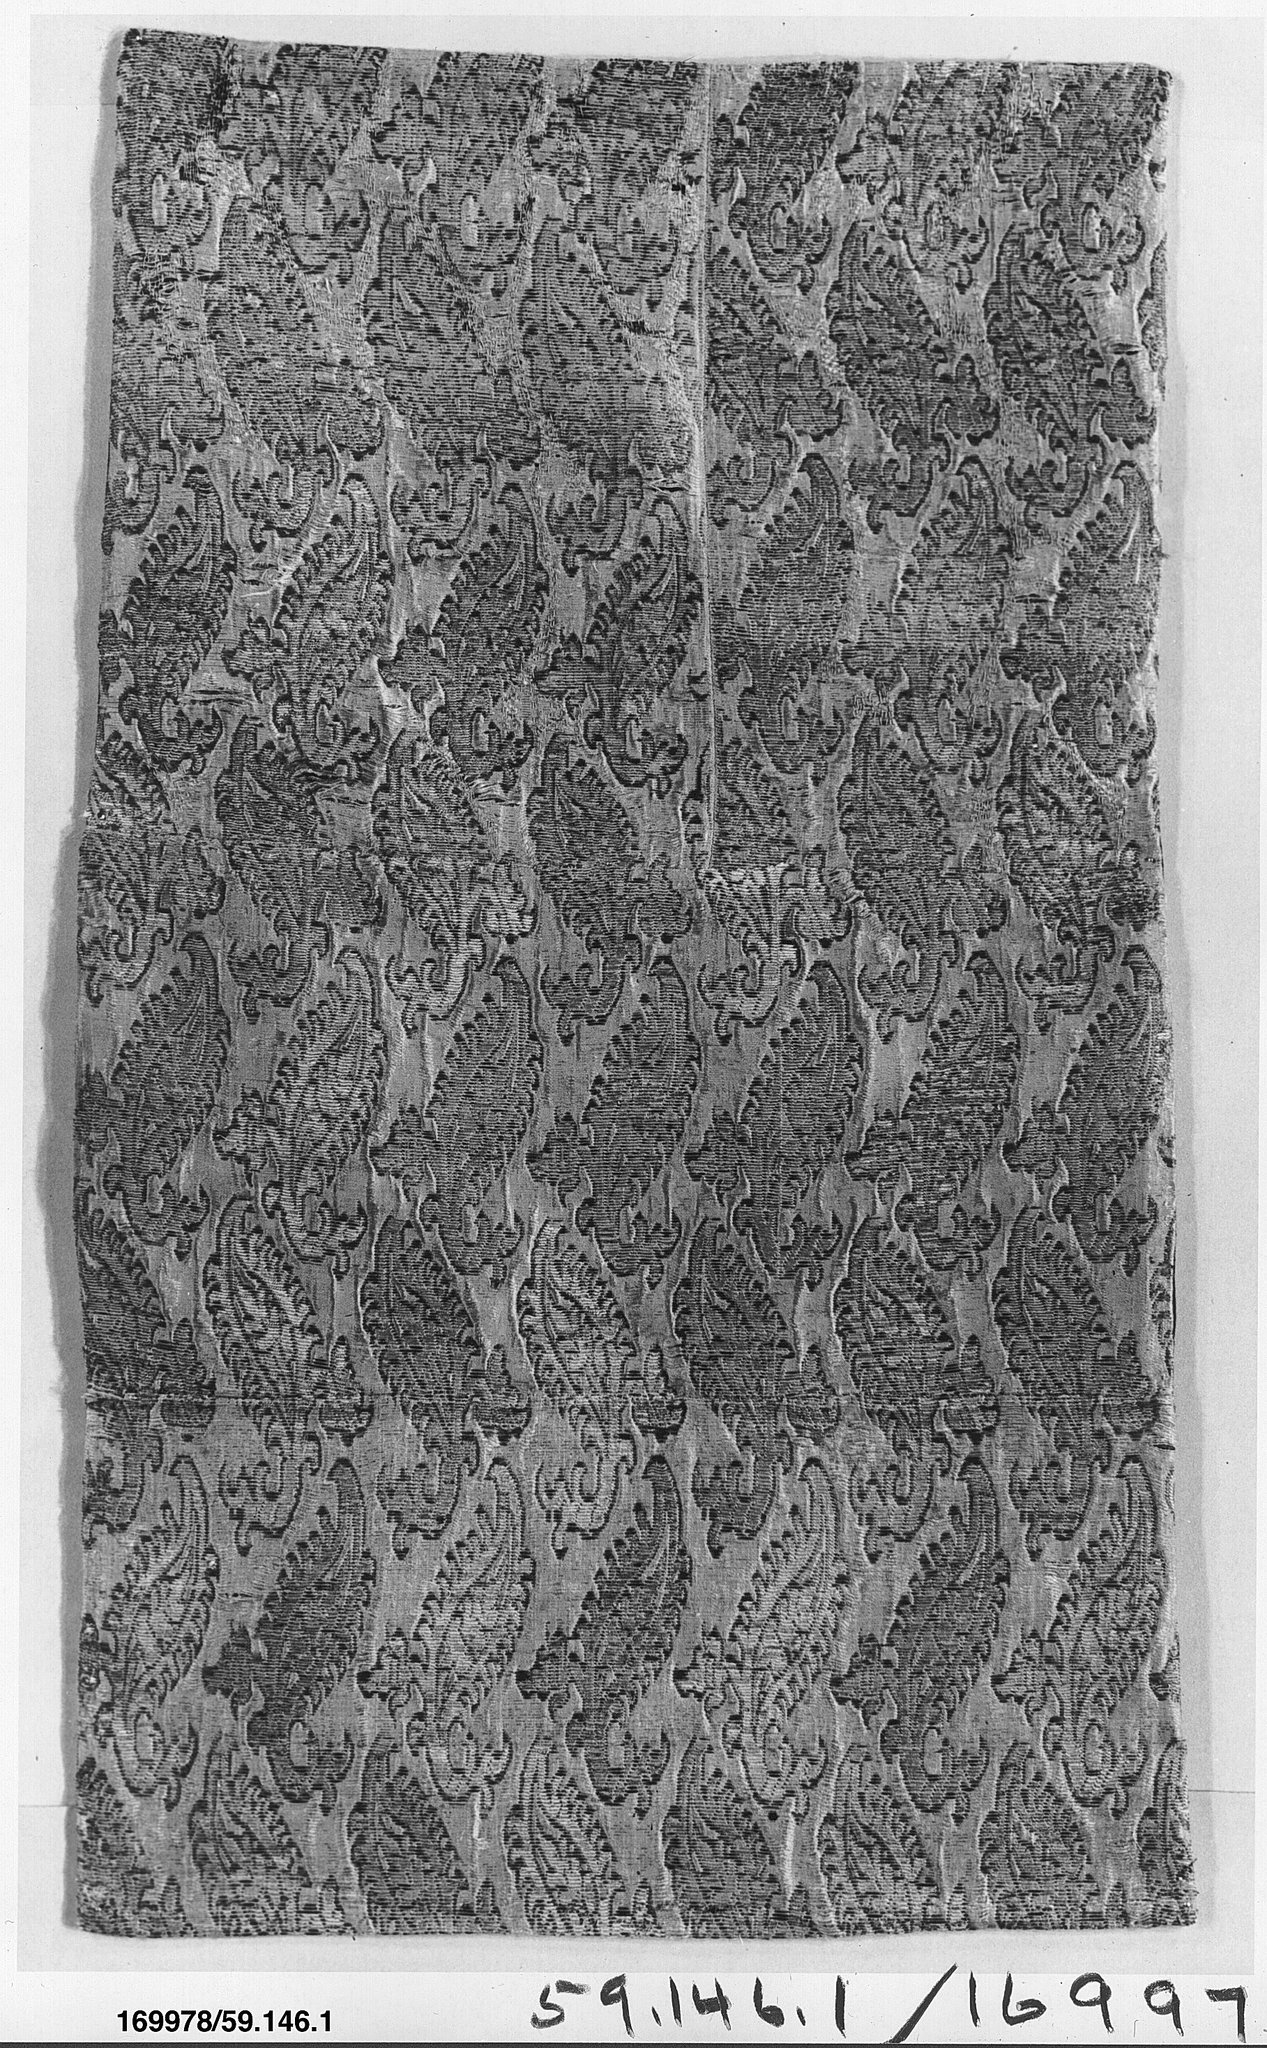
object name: piece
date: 1601-1700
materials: metal thread, silk